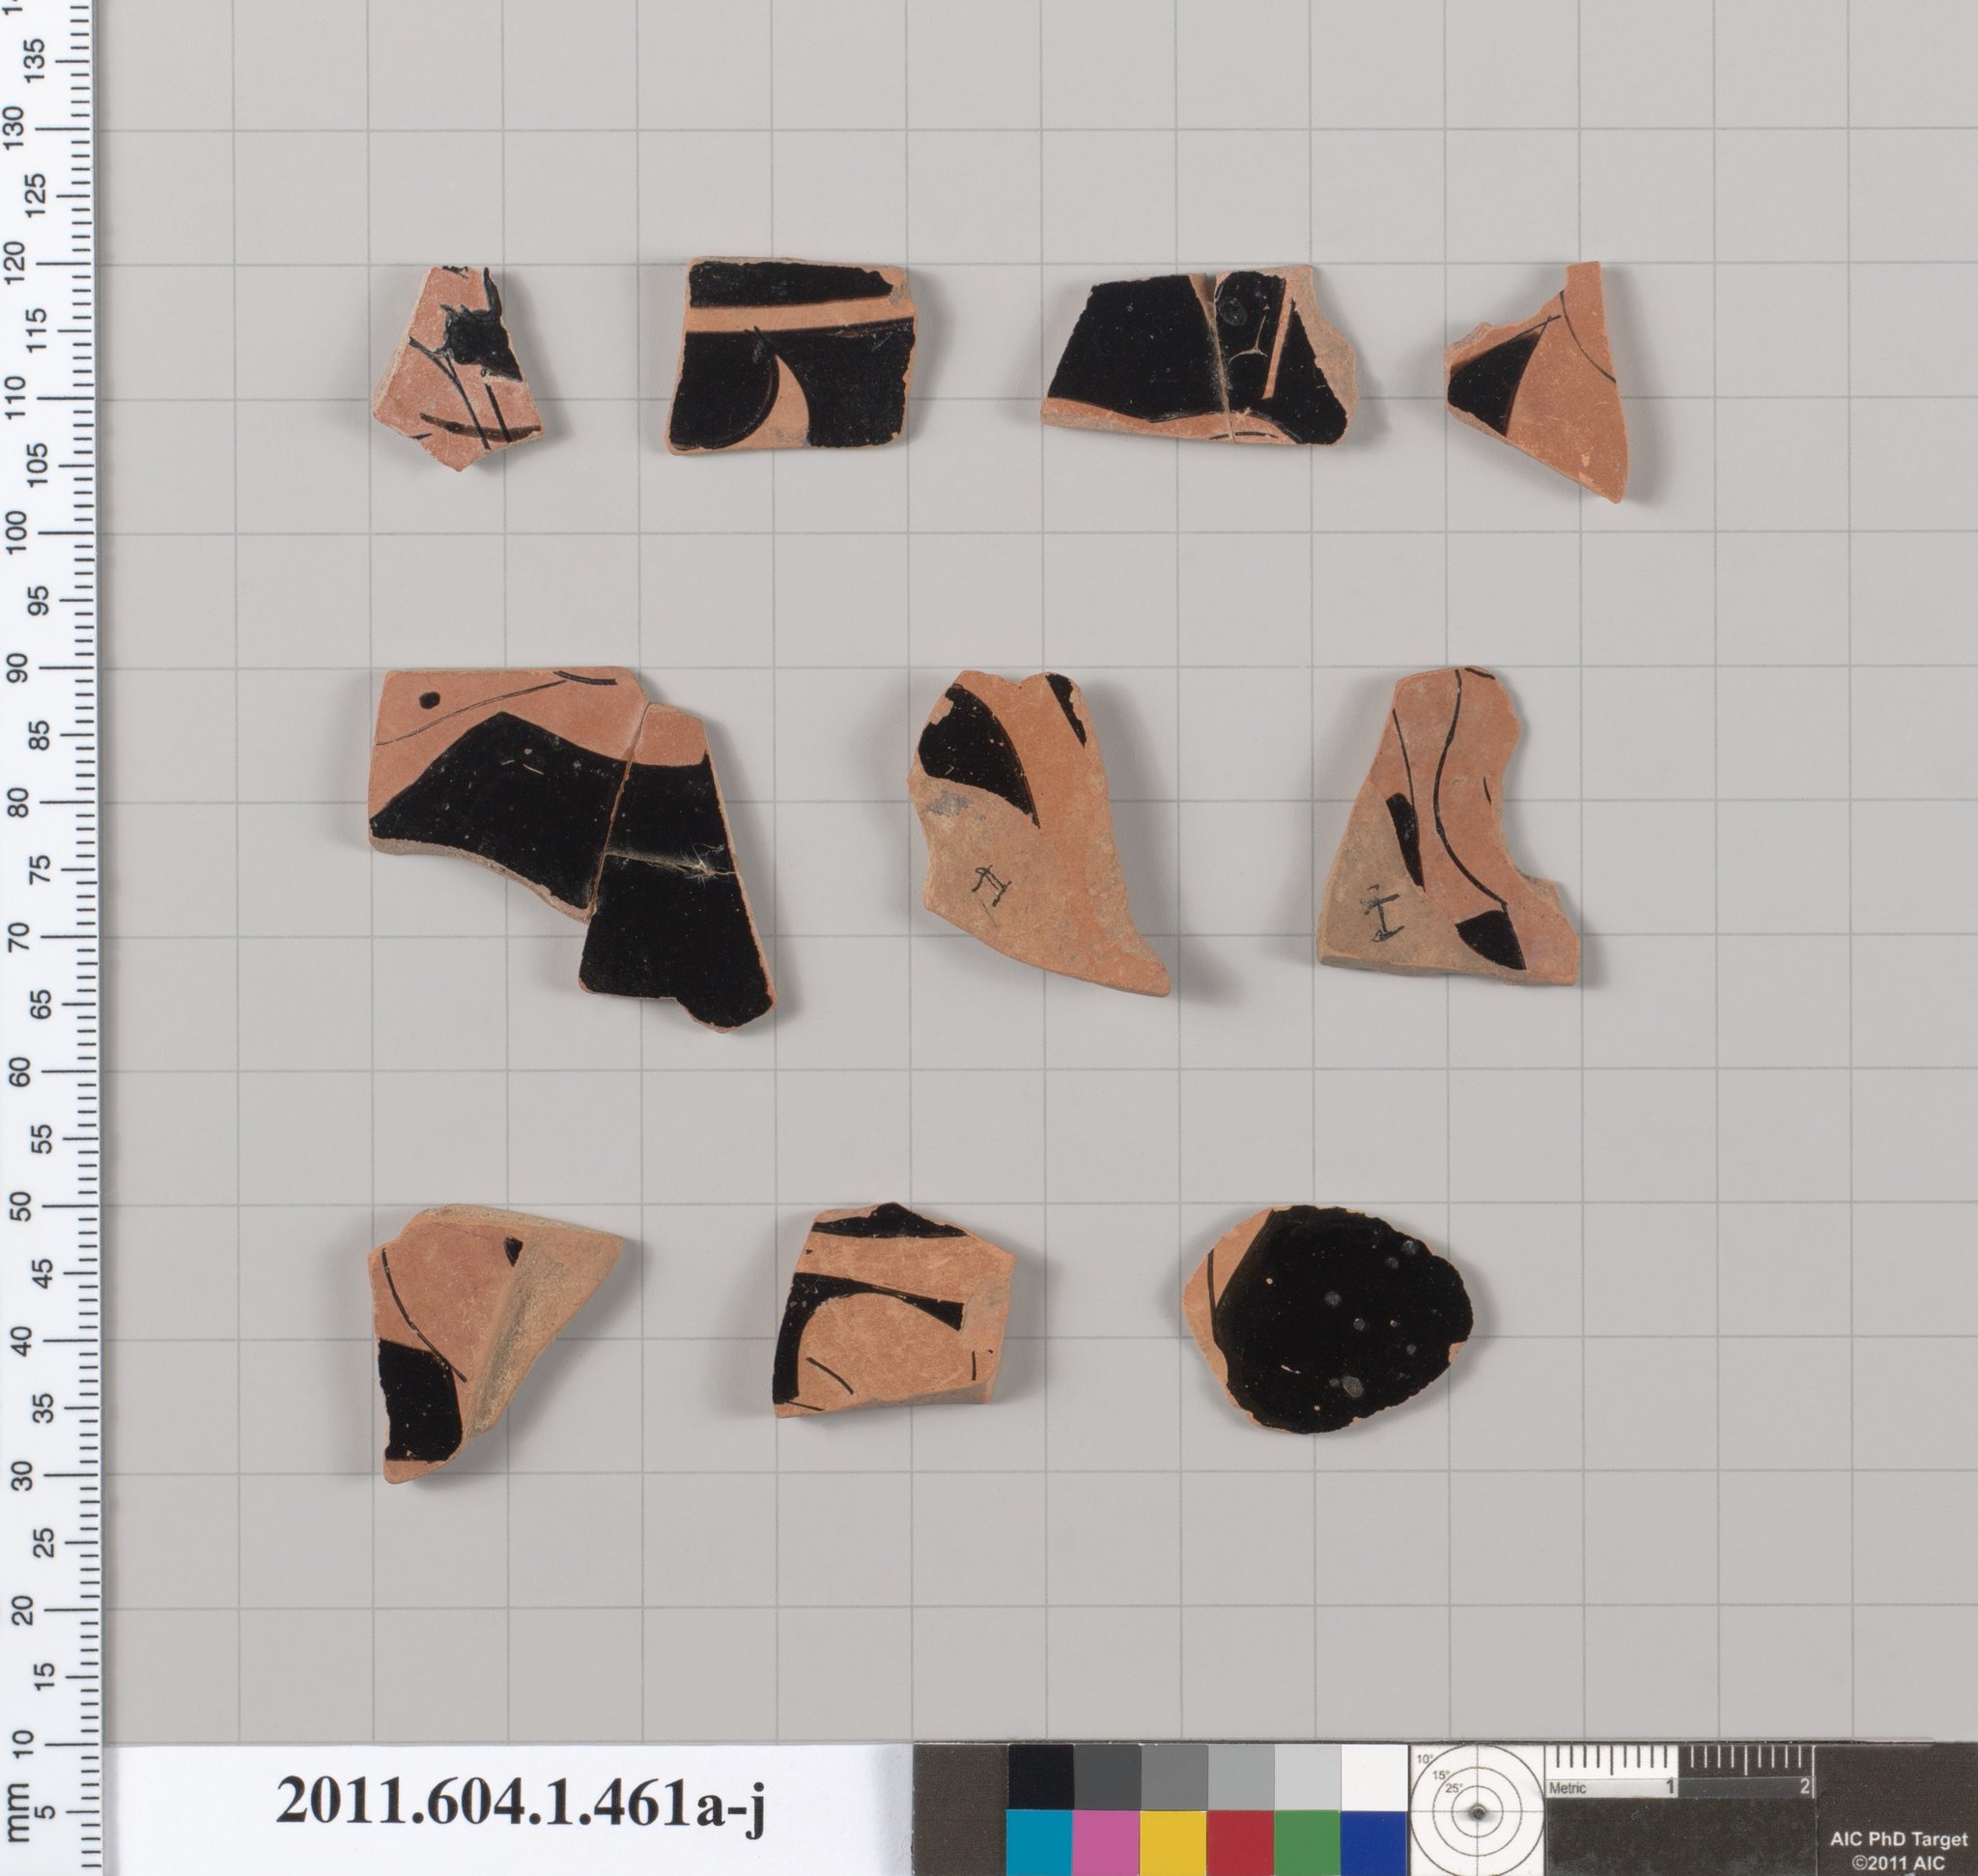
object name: kylix fragment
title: Terracotta fragments of kylikes (drinking cups)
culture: greek, attic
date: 401-500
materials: terracotta